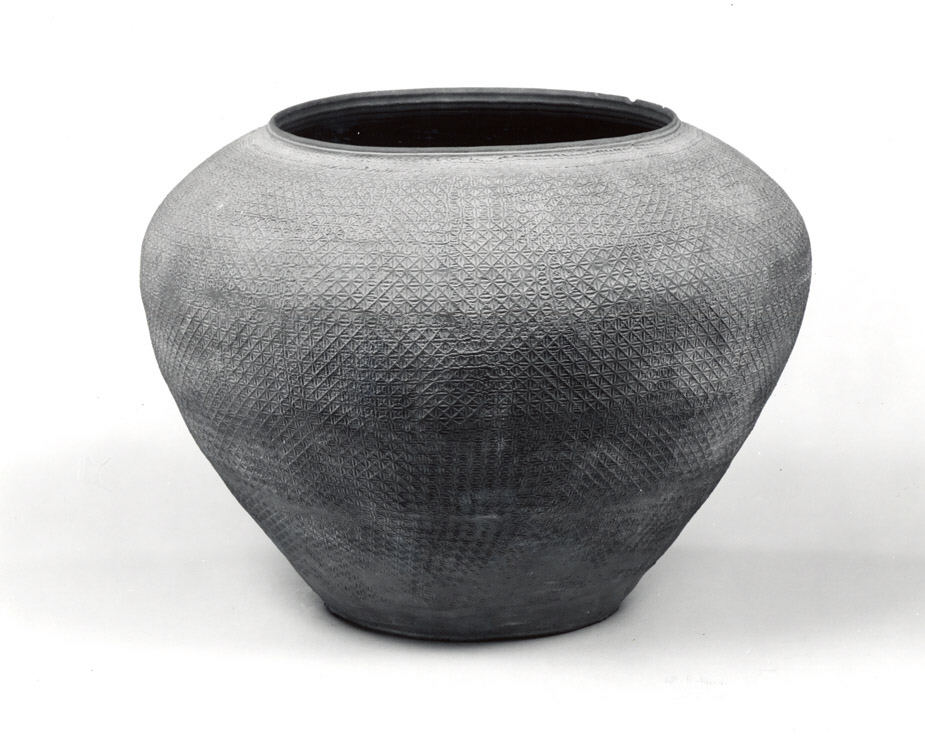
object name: jar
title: Wide-Mouthed Jar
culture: chinese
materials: pottery